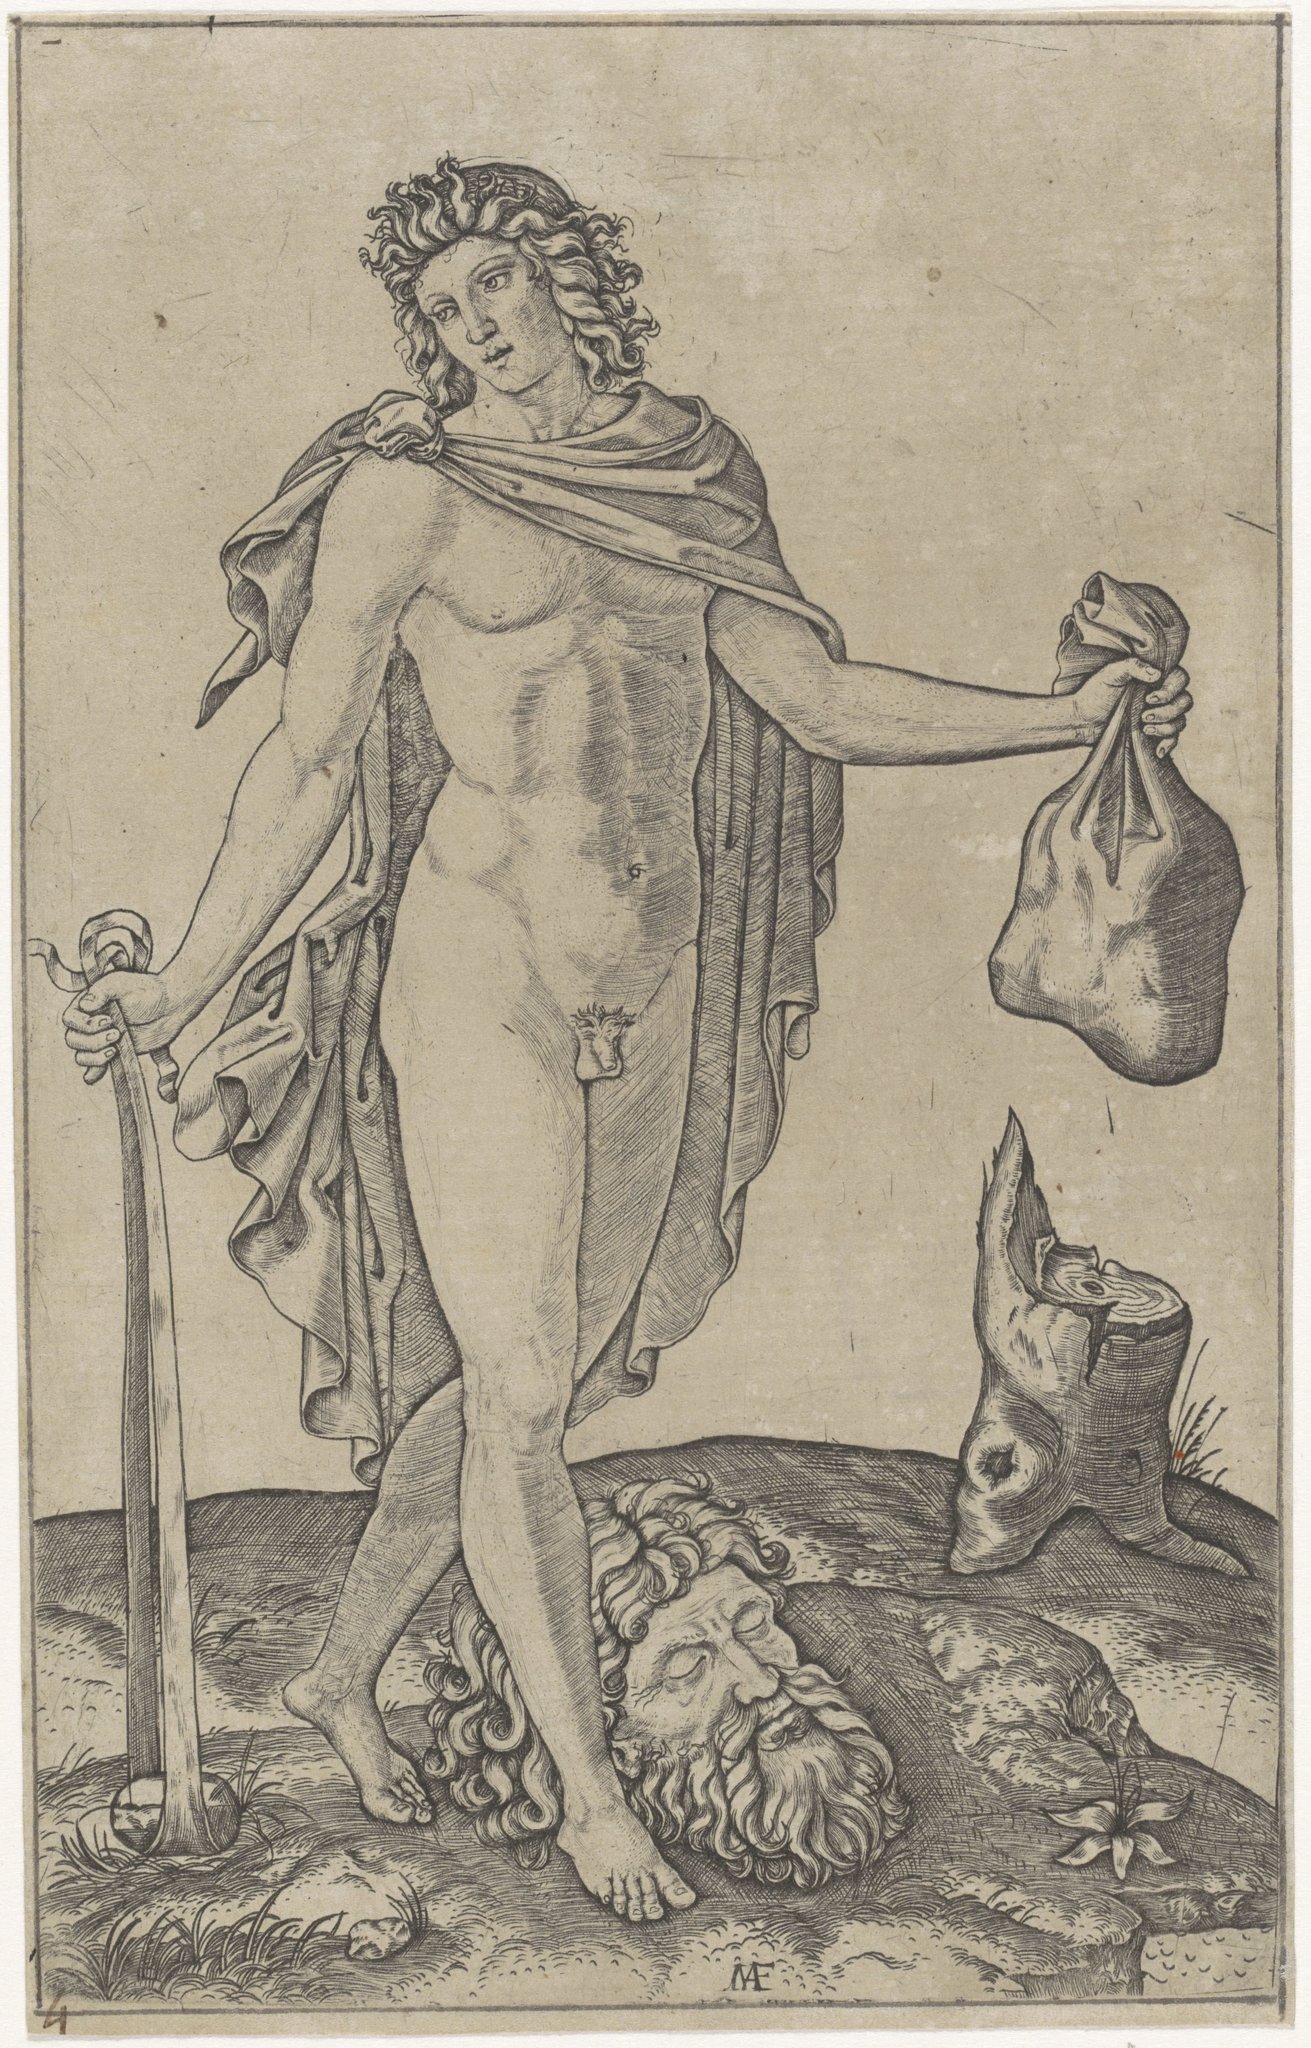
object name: print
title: David met slinger en zak stenen en hoofd van Goliat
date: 1504-1508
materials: paper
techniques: engraving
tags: david with goliath's head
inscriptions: number: ‘4’, collector's mark: Lugt 10, collector's mark: Lugt 11